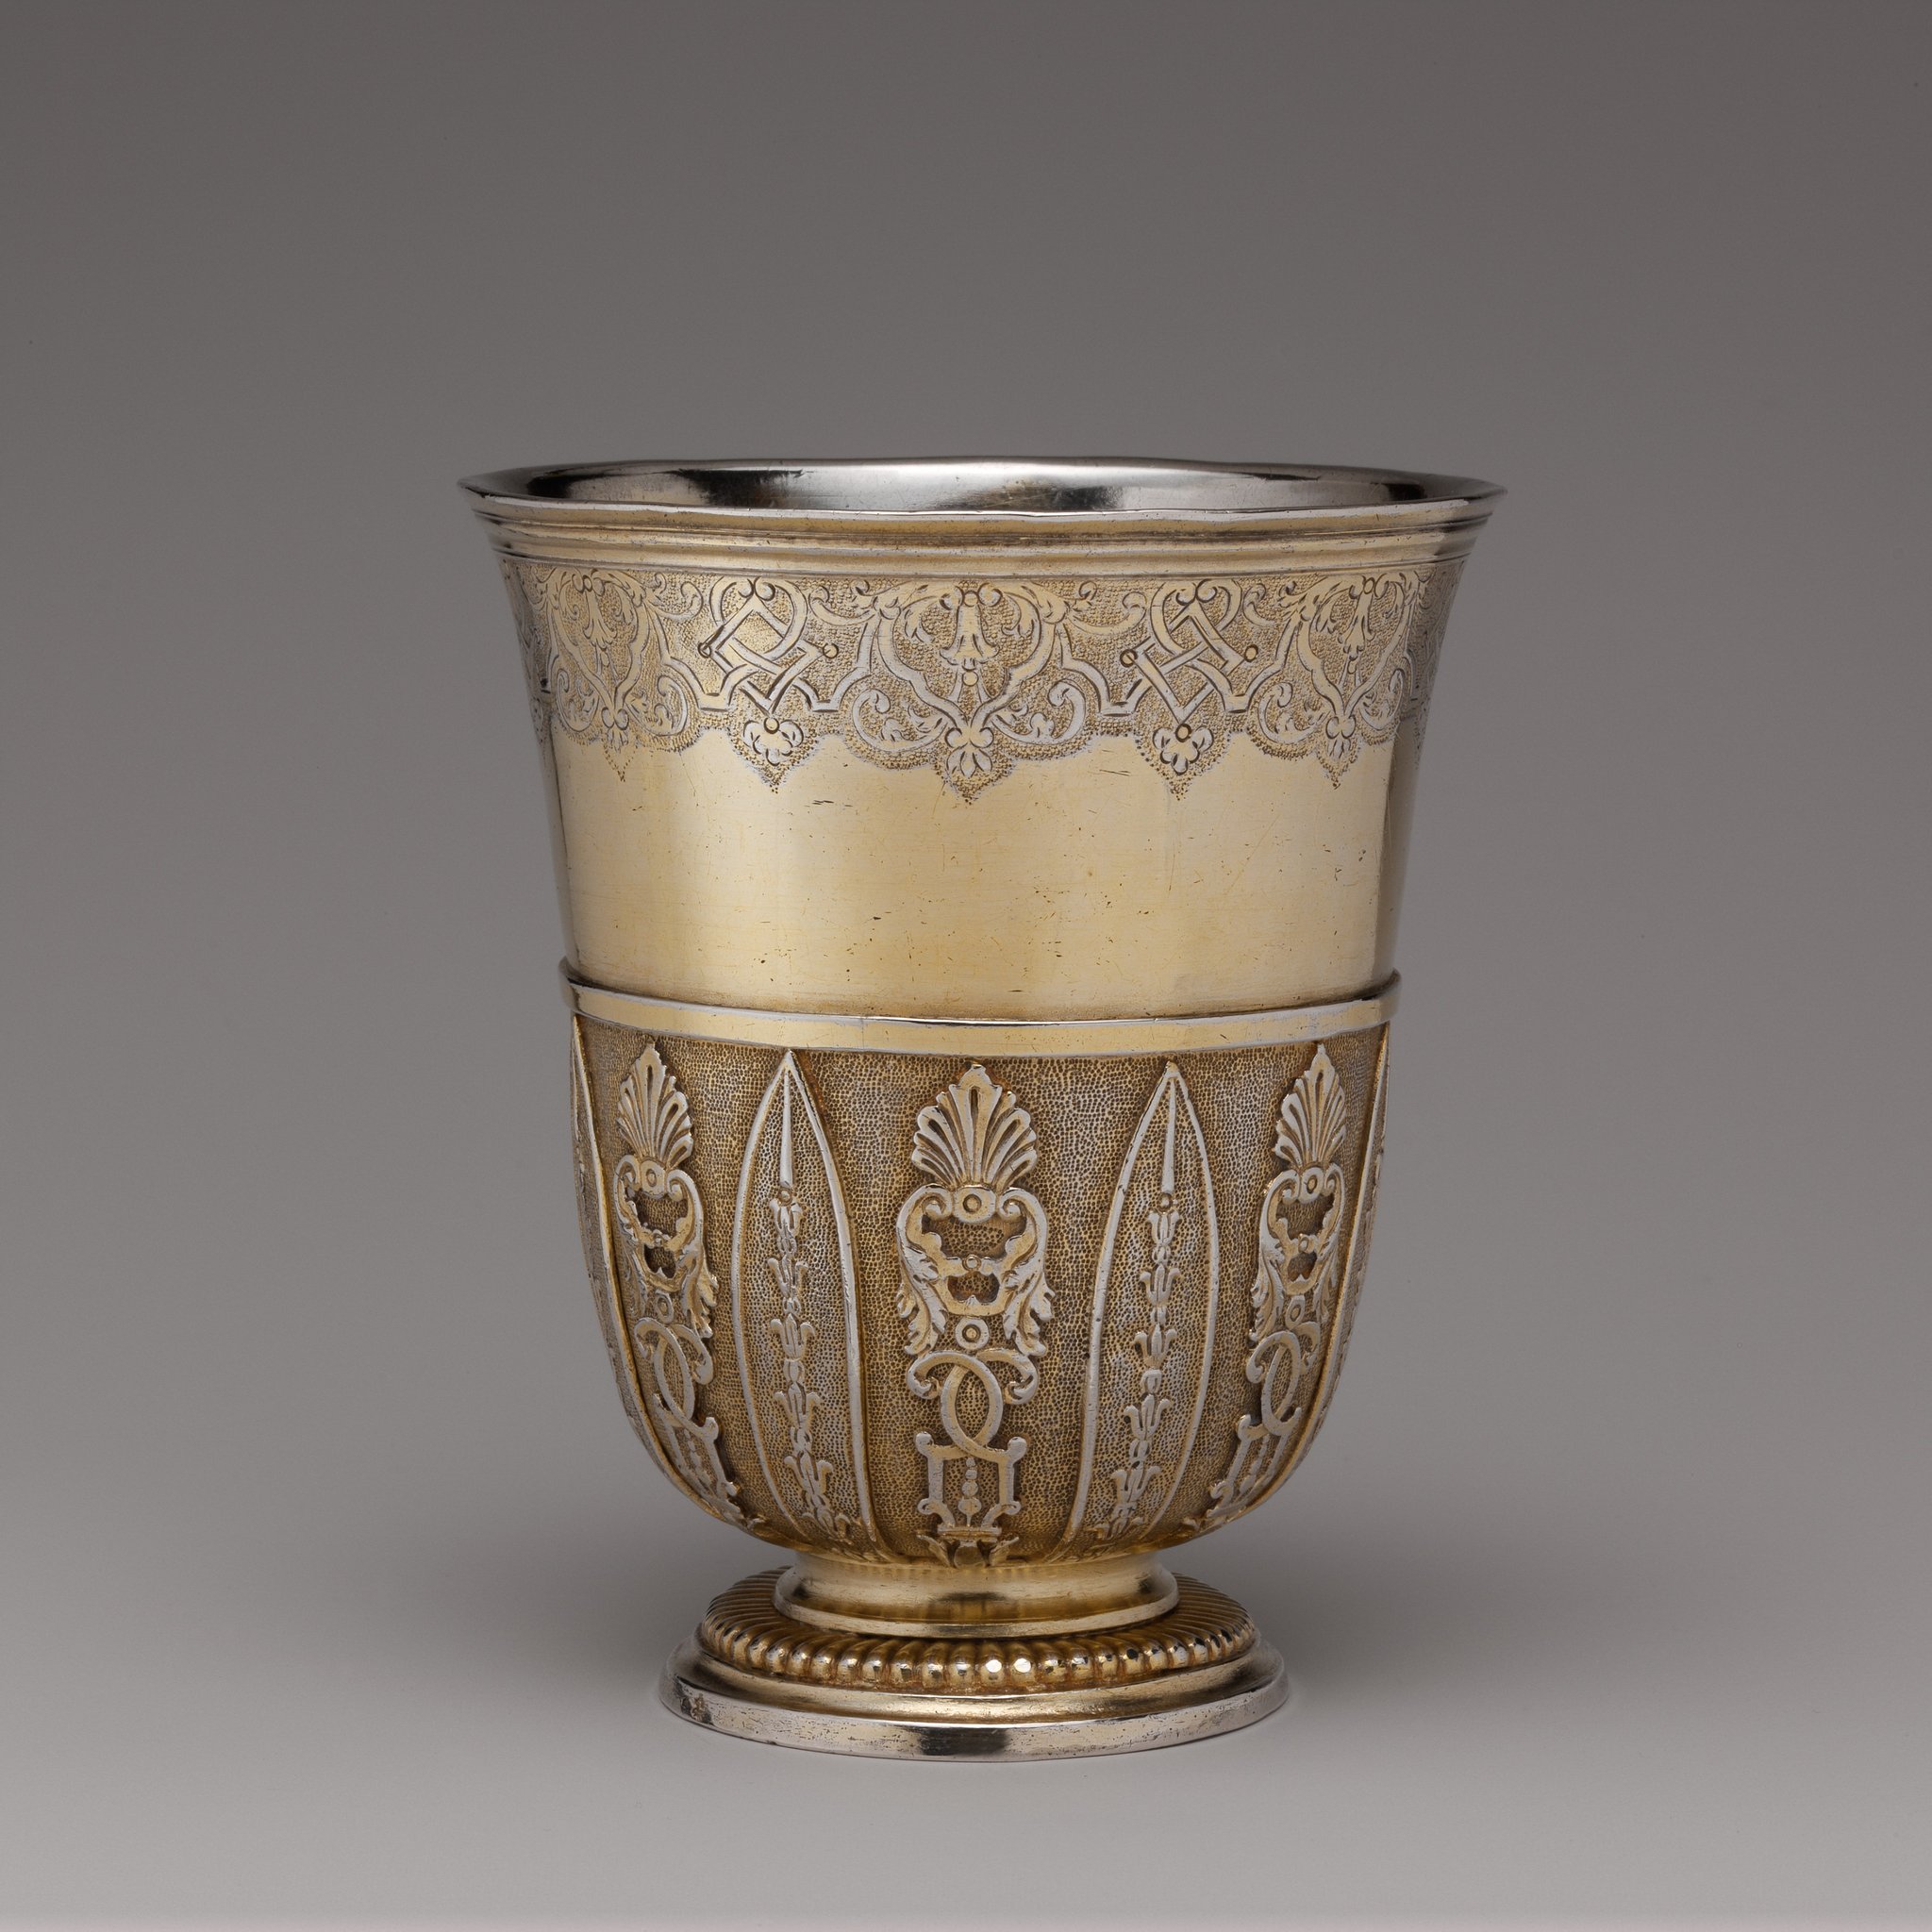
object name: beaker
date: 1713-1714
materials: gilt silver